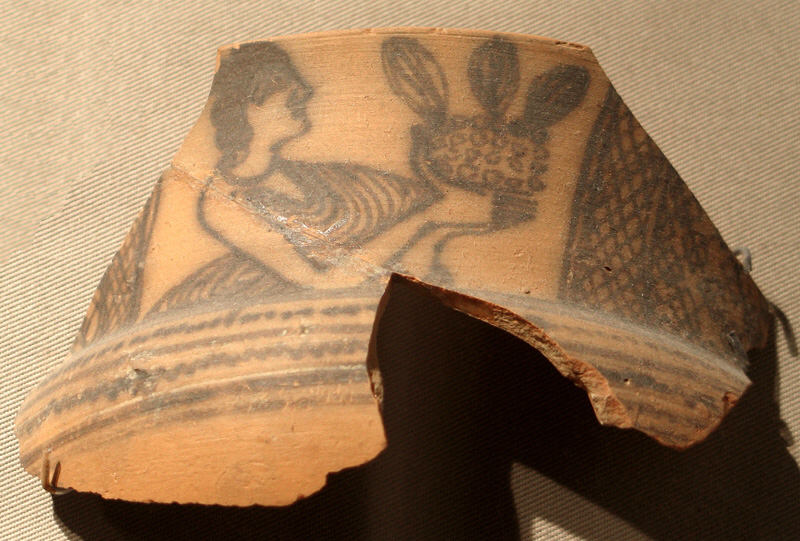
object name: shard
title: Shard: Neckpiece with Female Offerer and Crosshatched Ornamentation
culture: pakistani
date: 301-500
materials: terracotta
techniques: painting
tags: gandhara,women